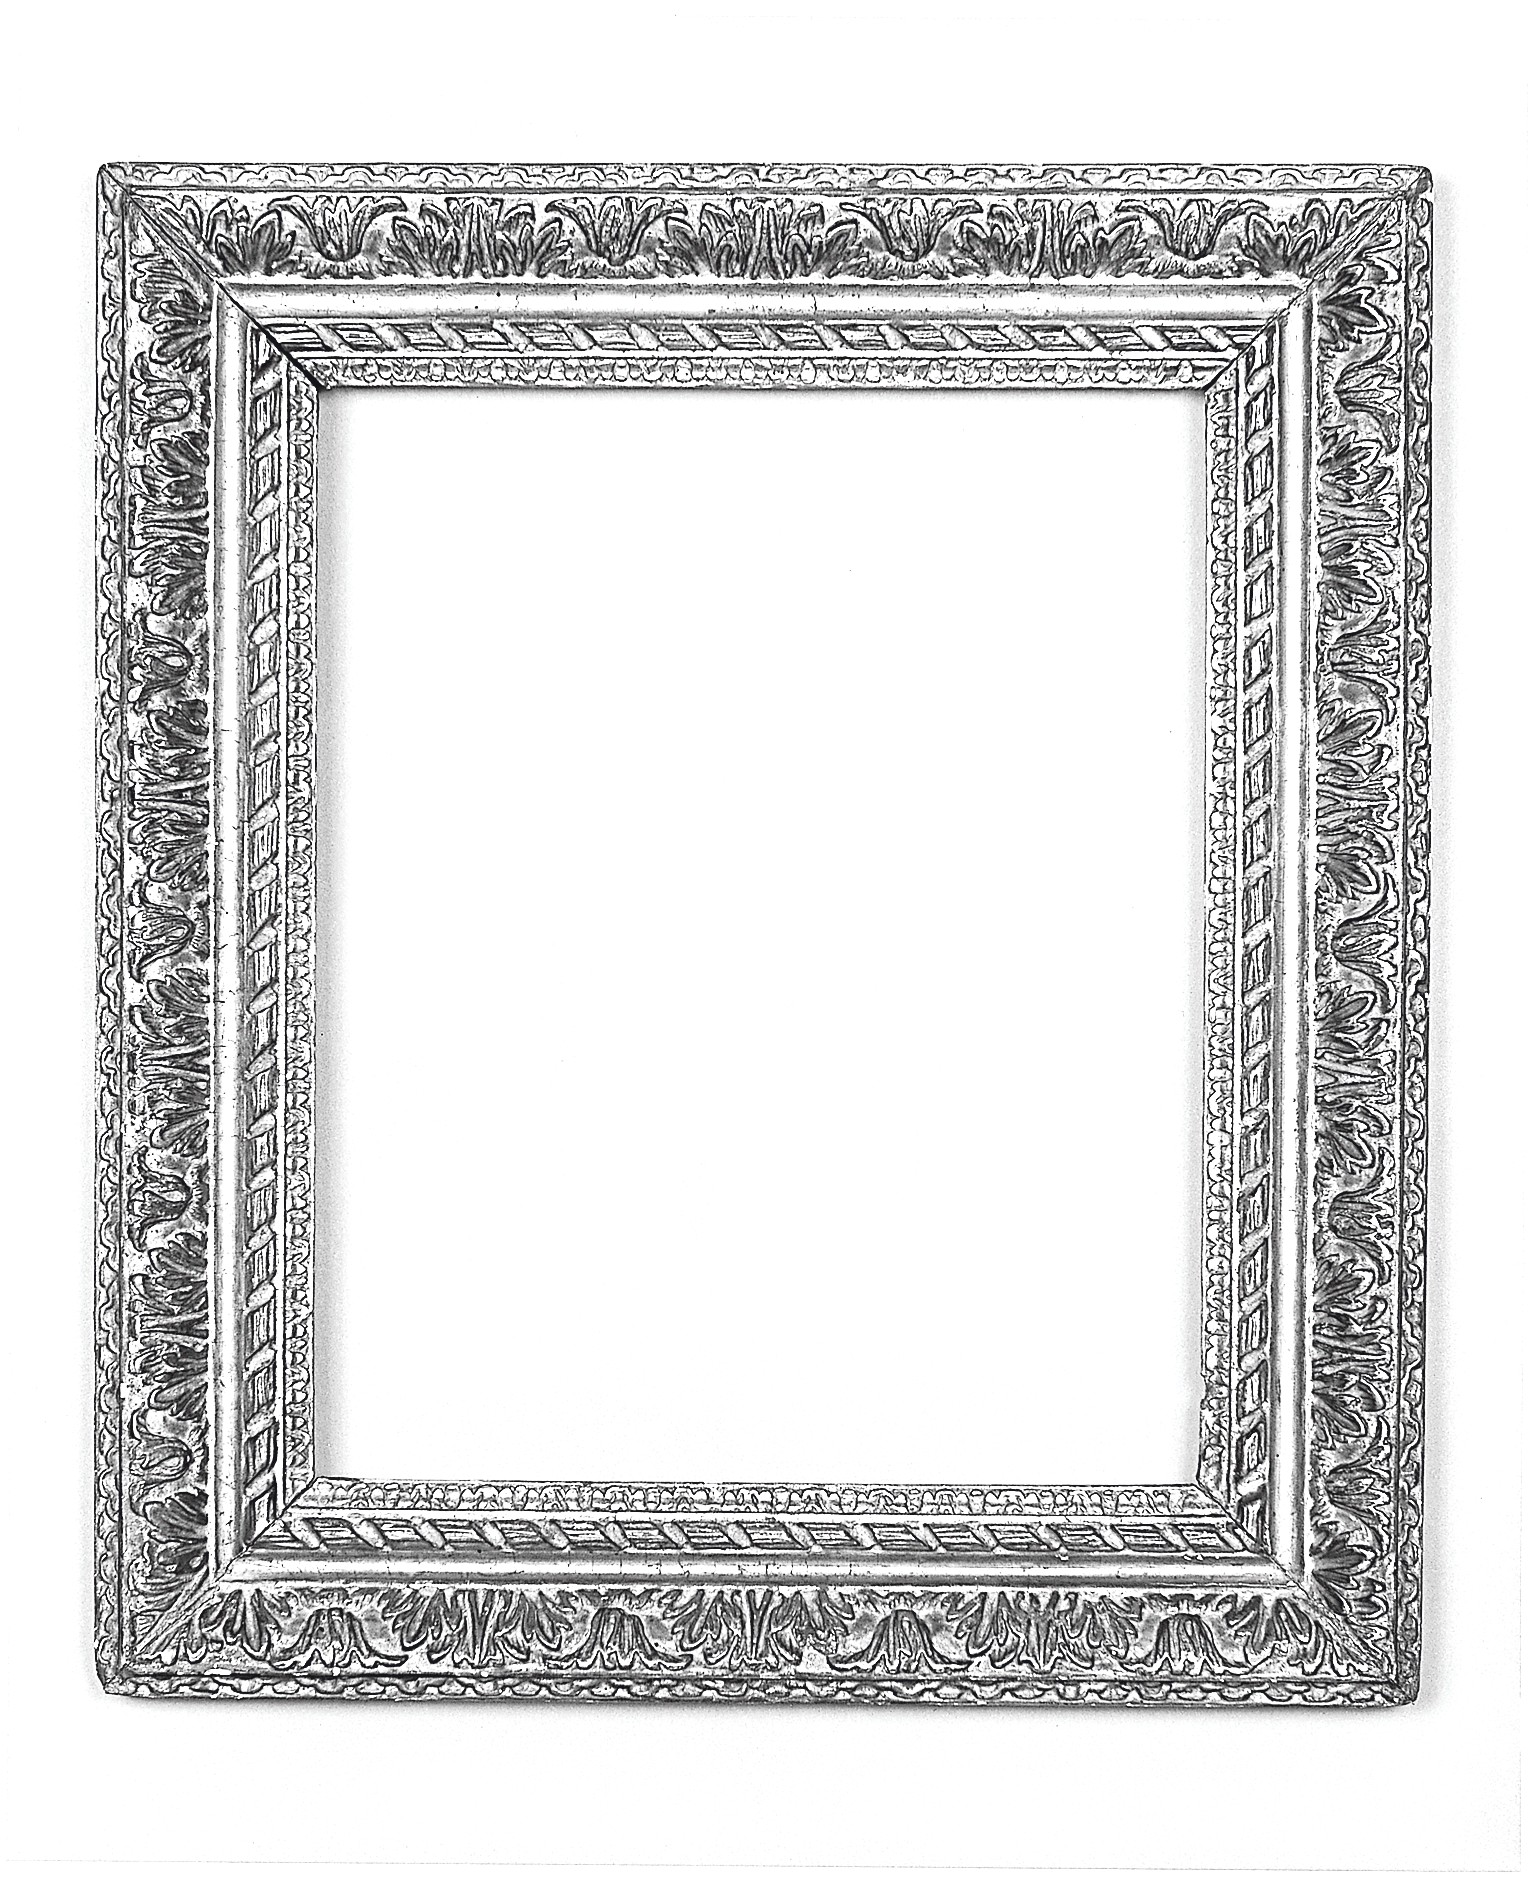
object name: frame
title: Ovolo frame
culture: french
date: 1640-1650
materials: feather, wood